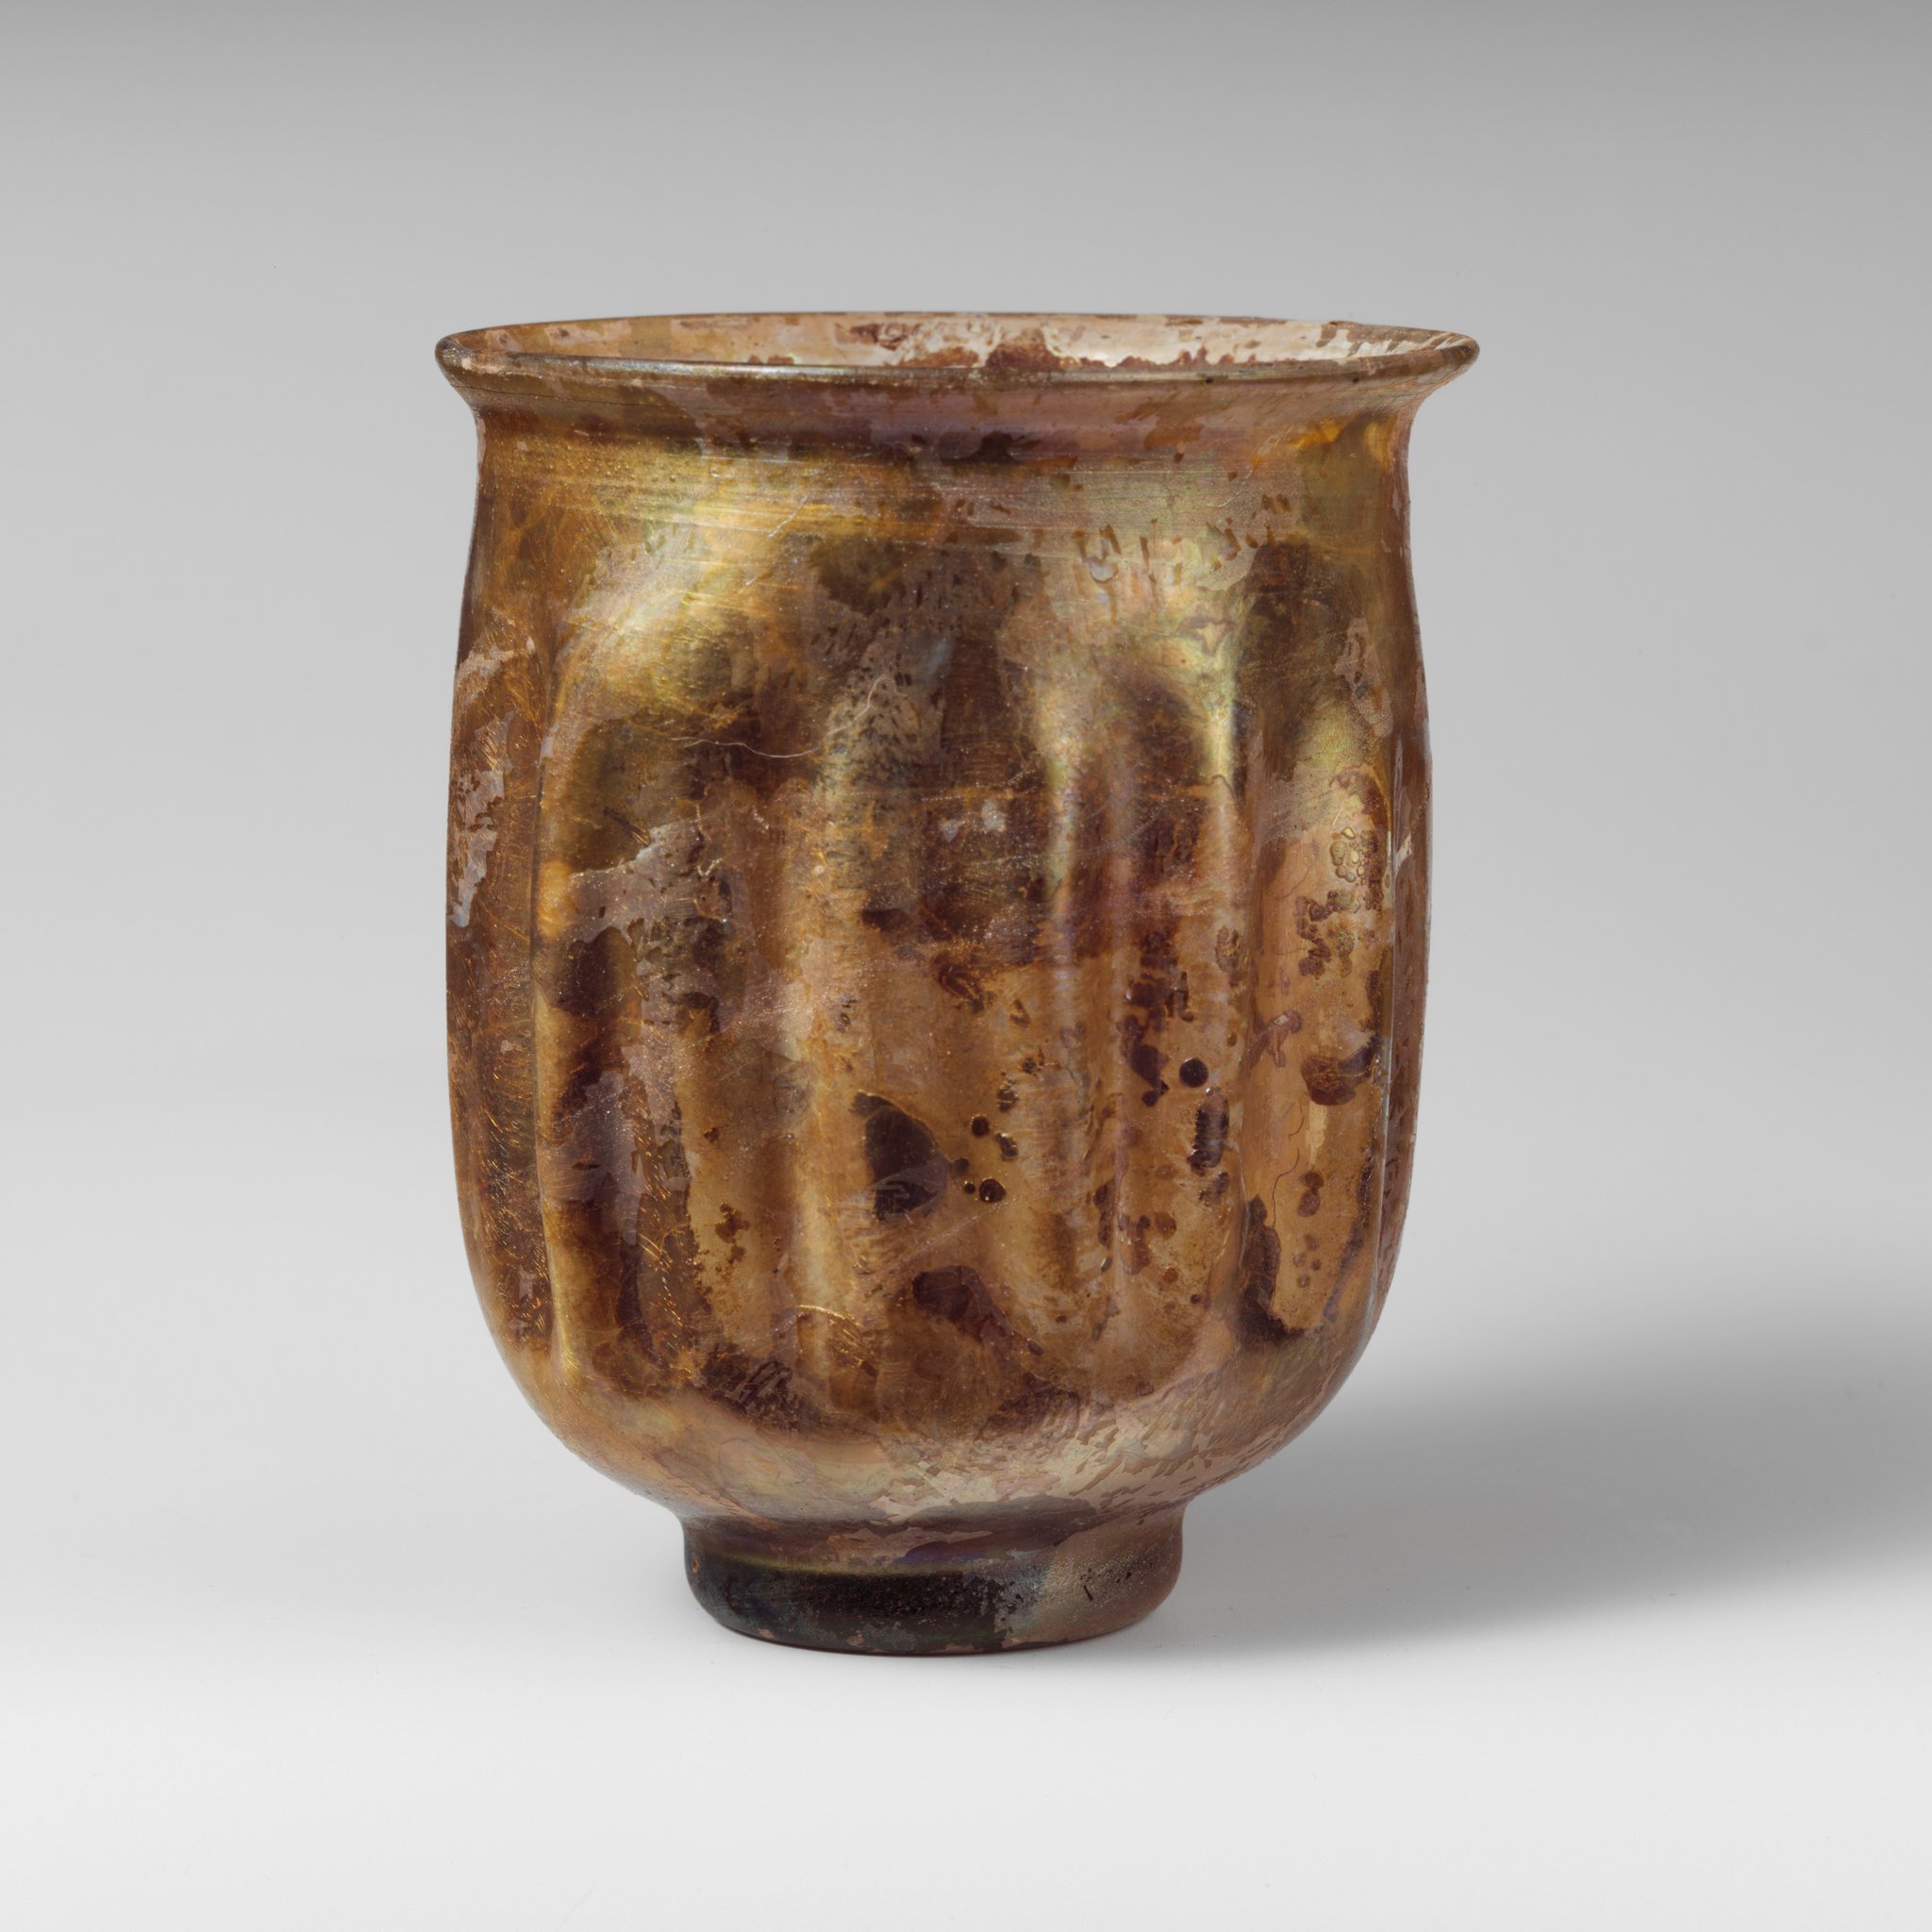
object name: beaker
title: Glass beaker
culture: roman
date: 101-300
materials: glass